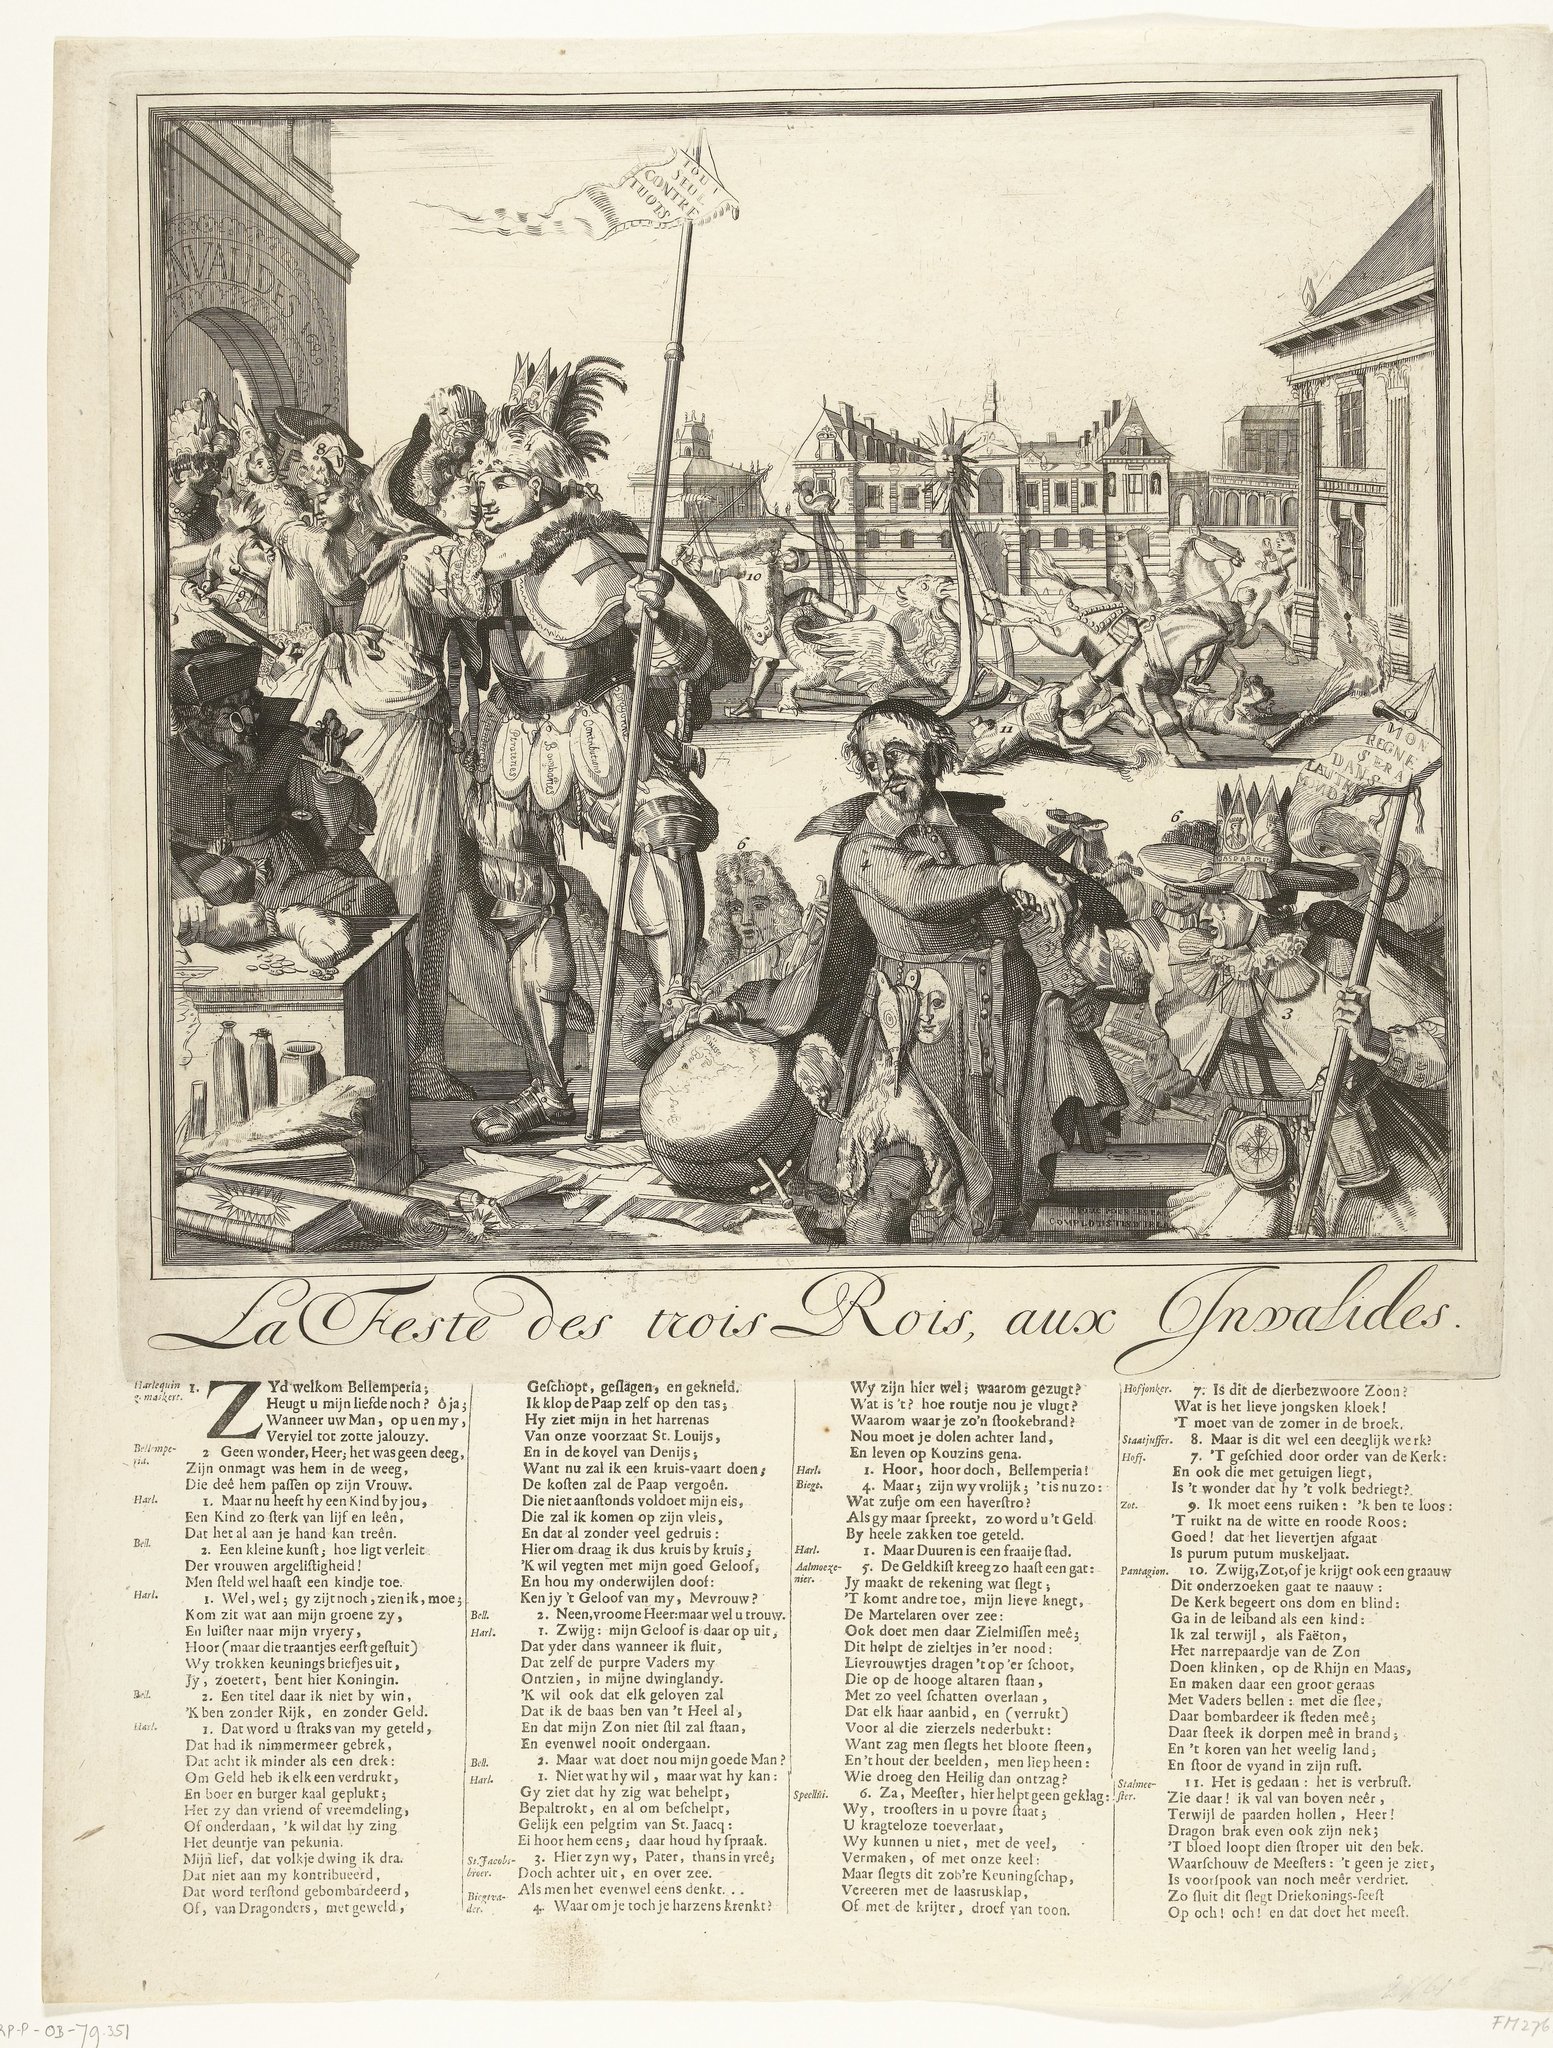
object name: print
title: La Feste des Trois Rois, aux Invalides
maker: Anonymous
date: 1689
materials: paper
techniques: engraving, etching, letterpress printing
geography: northern netherlands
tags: jacobus ii (koning van engeland en schotland), lodewijk xiv (koning van frankrijk), paris, dauphin van frankrijk lodewijk, rome, twelfth night, usually falling on the eve of january 6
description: Spotprent op de vlucht van Jacobus II naar Frankrijk, en zijn aankomst aldaar op Driekoningen (6 januari) 1689. Koning Lodewijk XI omhelst Maria van Modena die met het ondergeschoven kind is gearriveerd. Rechtsvoor koning Jacobus II in kleding versierd met Jacobsschelpen. In het midden de jezuïet pater Peters (Edward Petre) met een pauselijke kroon onder zijn mantel. Op de achtergrond valt de dauphin uit een door paarden getrokken slee. Onder de voorstelling een vers in 4 kolommen met een verklaring van de cijfers 1-11 in het Nederlands. Anonieme kopie naar de originele prent door Romeyn de Hooghe.